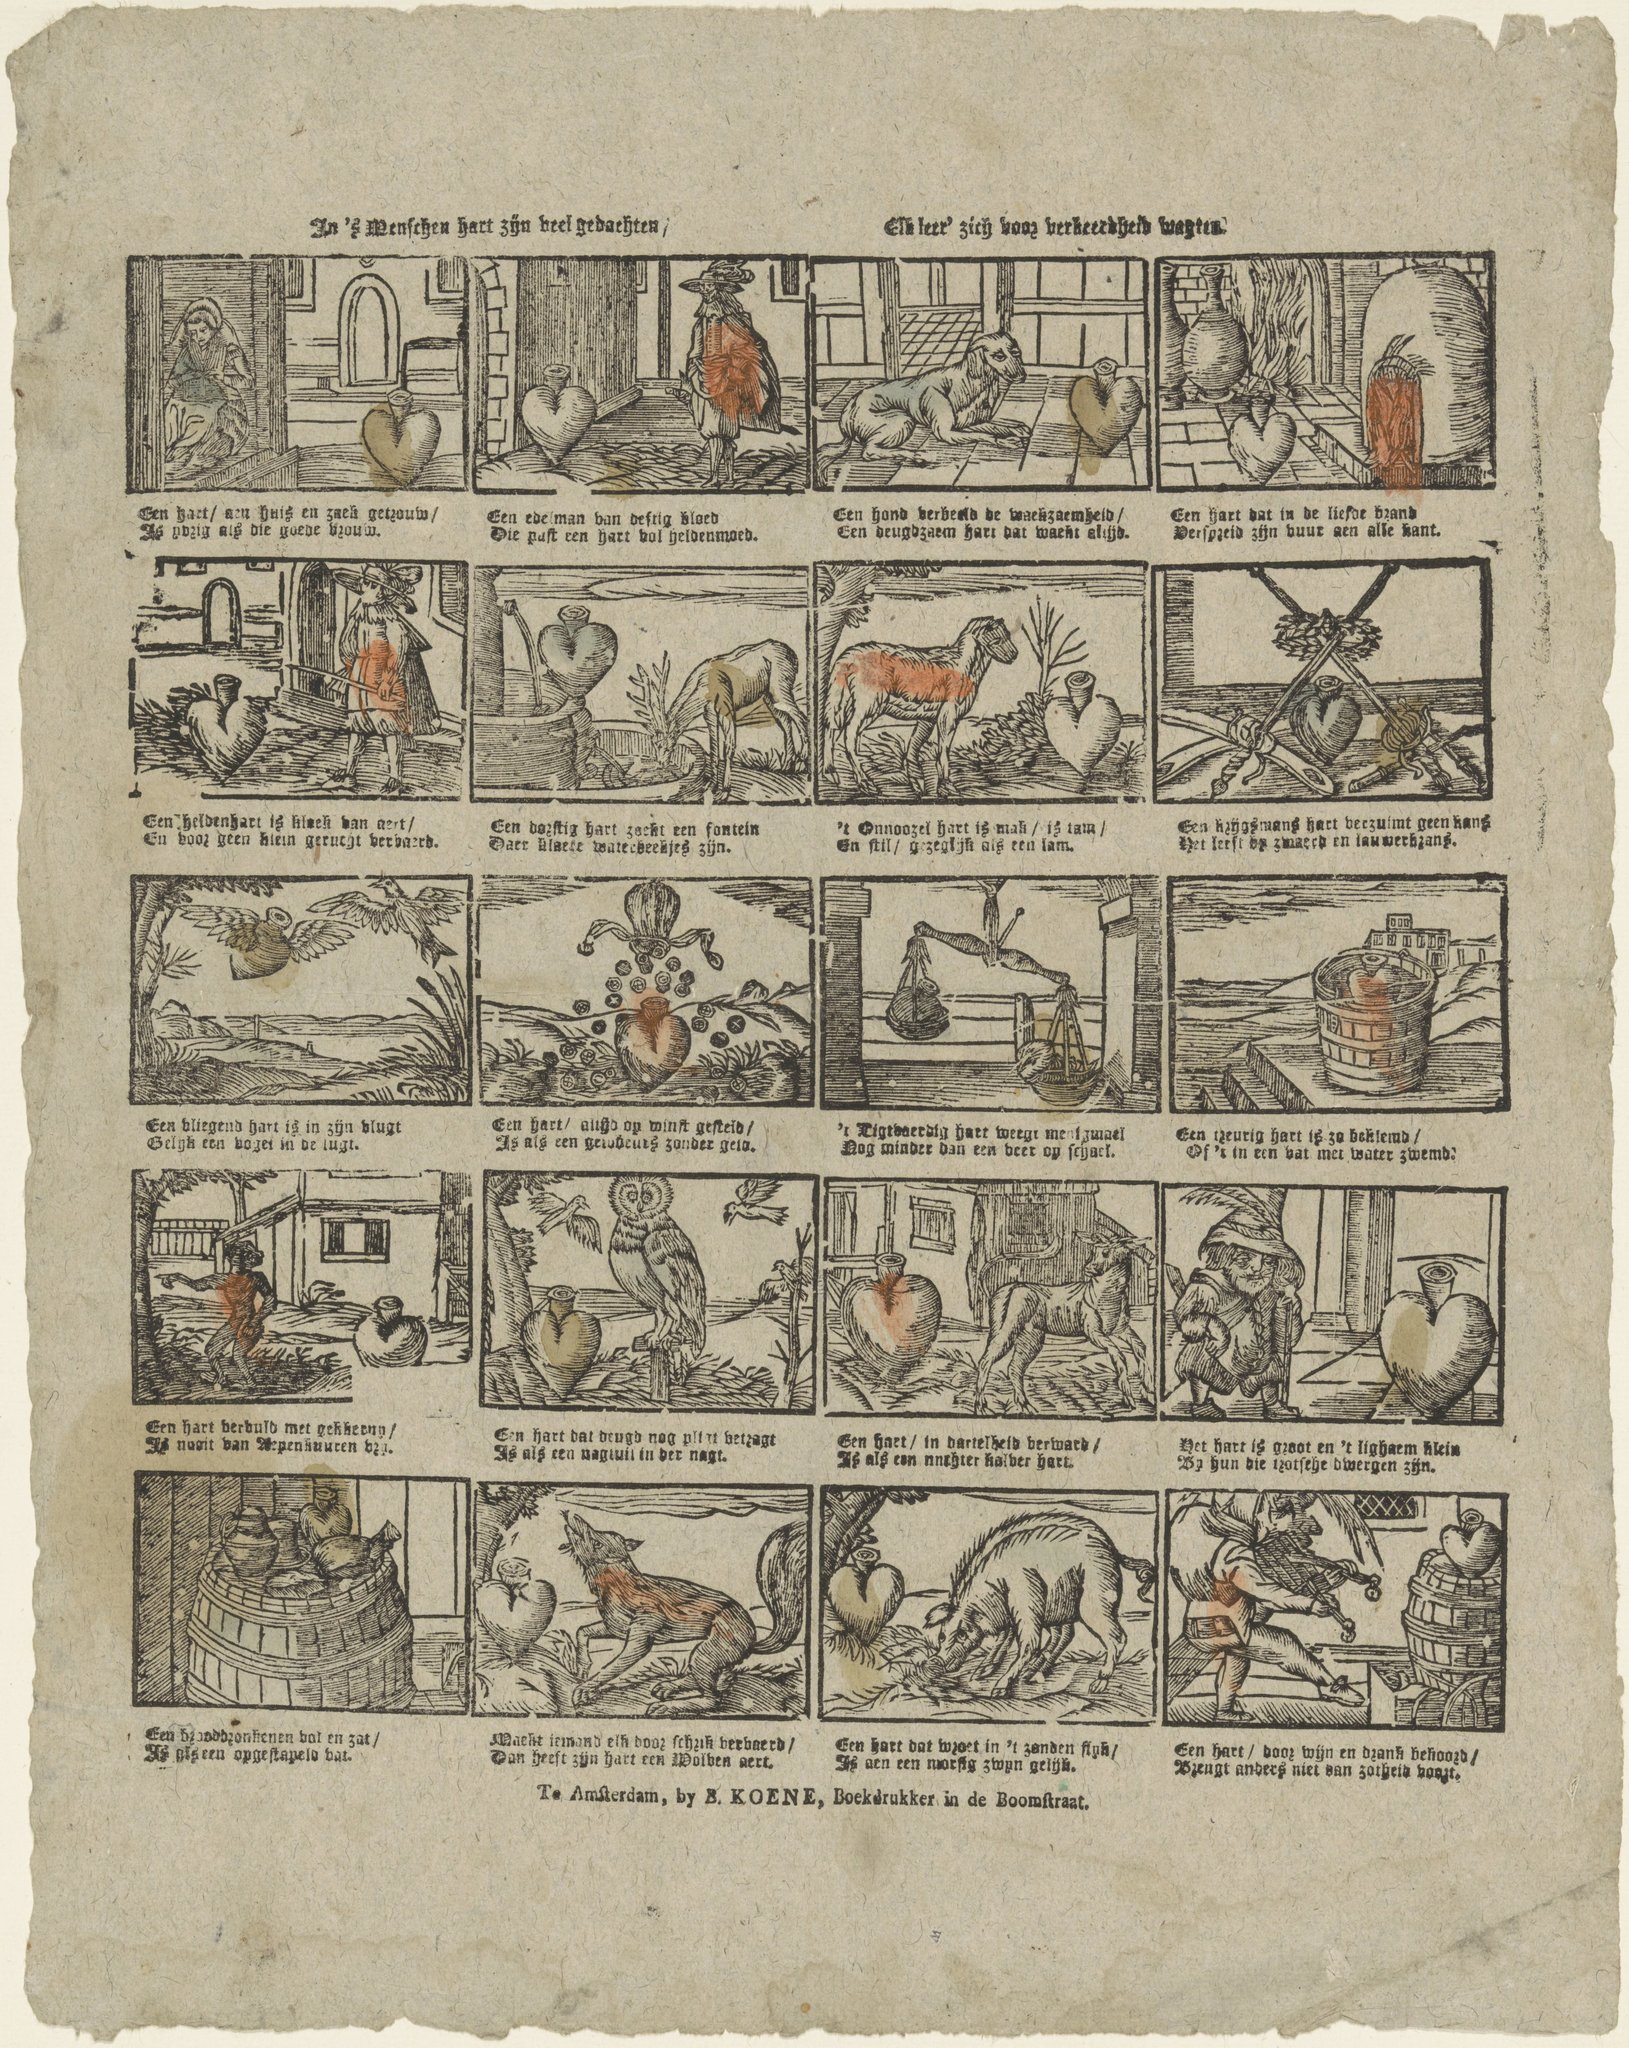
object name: popular print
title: In 's menschen hart zijn veel gedachten / Elk leer' zich voor verkeerdheid wagten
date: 1814-1830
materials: paper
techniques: colour, letterpress printing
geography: netherlands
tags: proverbs, sayings, etc.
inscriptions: collector's mark: Lugt 2760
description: Blad met 20 verbeeldingen van uitdrukkingen met het woord hart. Onder elke afbeelding een tweeregelig vers.